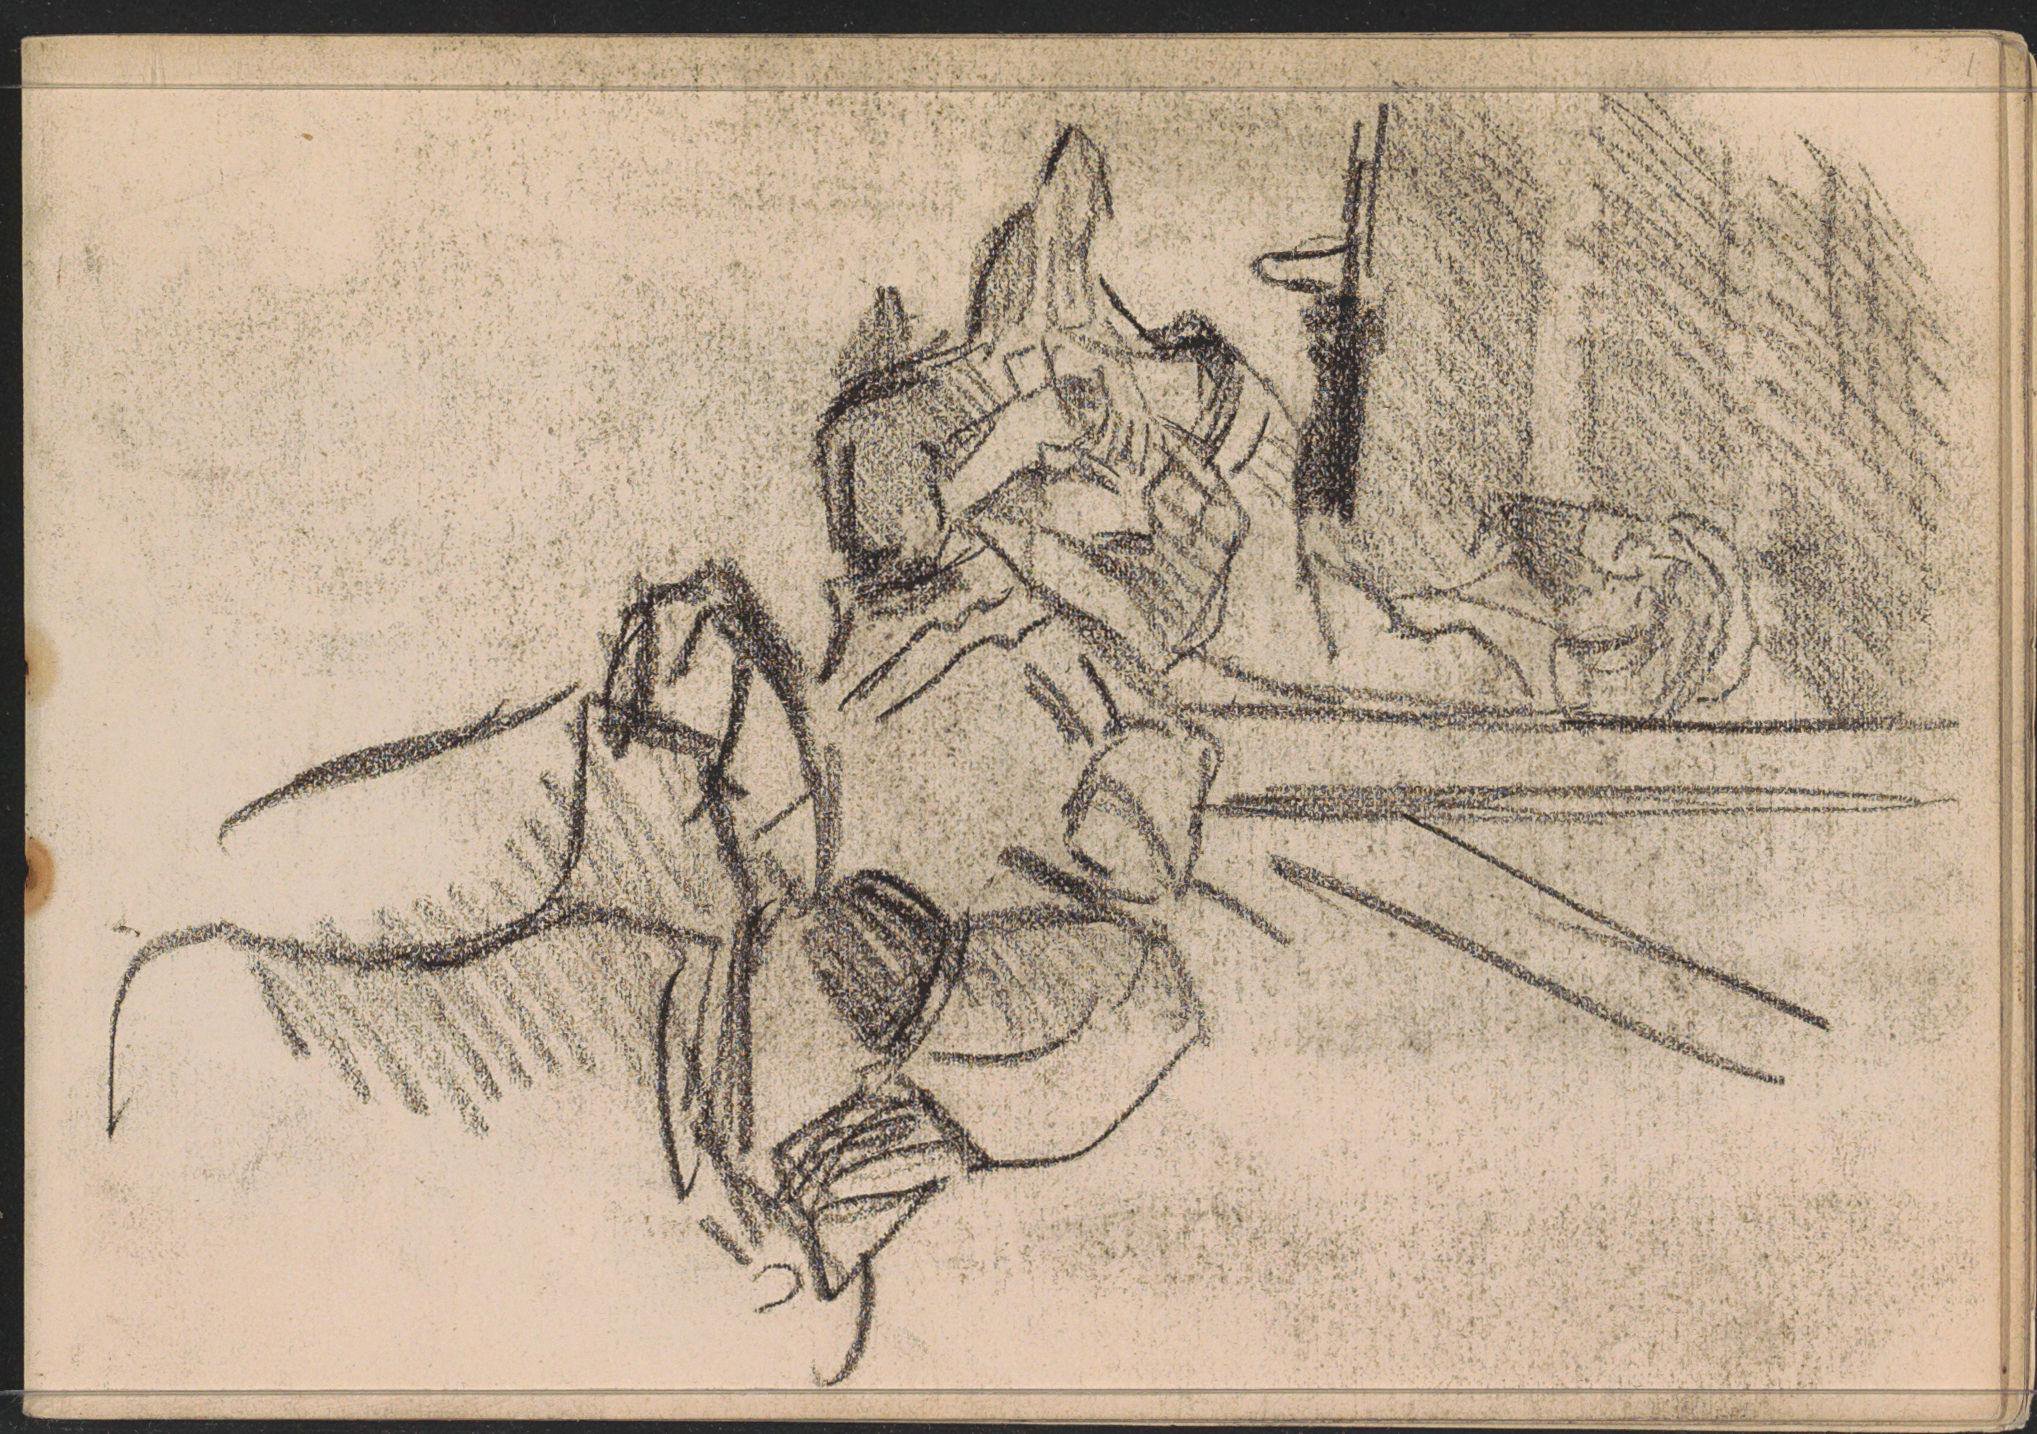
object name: sketchbook leaf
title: Liggende man, mogelijk slapend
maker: isaac israels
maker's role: draughtsman, painter, print maker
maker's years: 1865-1934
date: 1875-1934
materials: chalk, paper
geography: the hague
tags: adult man (+ lying), the (nude) human figure; 'corpo humano' (ripa) (+ sitting), sleeping on the ground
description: Op de achtergrond een zittende figuur. Pagina 1 uit schetsboek XLII met 32 pagina's.